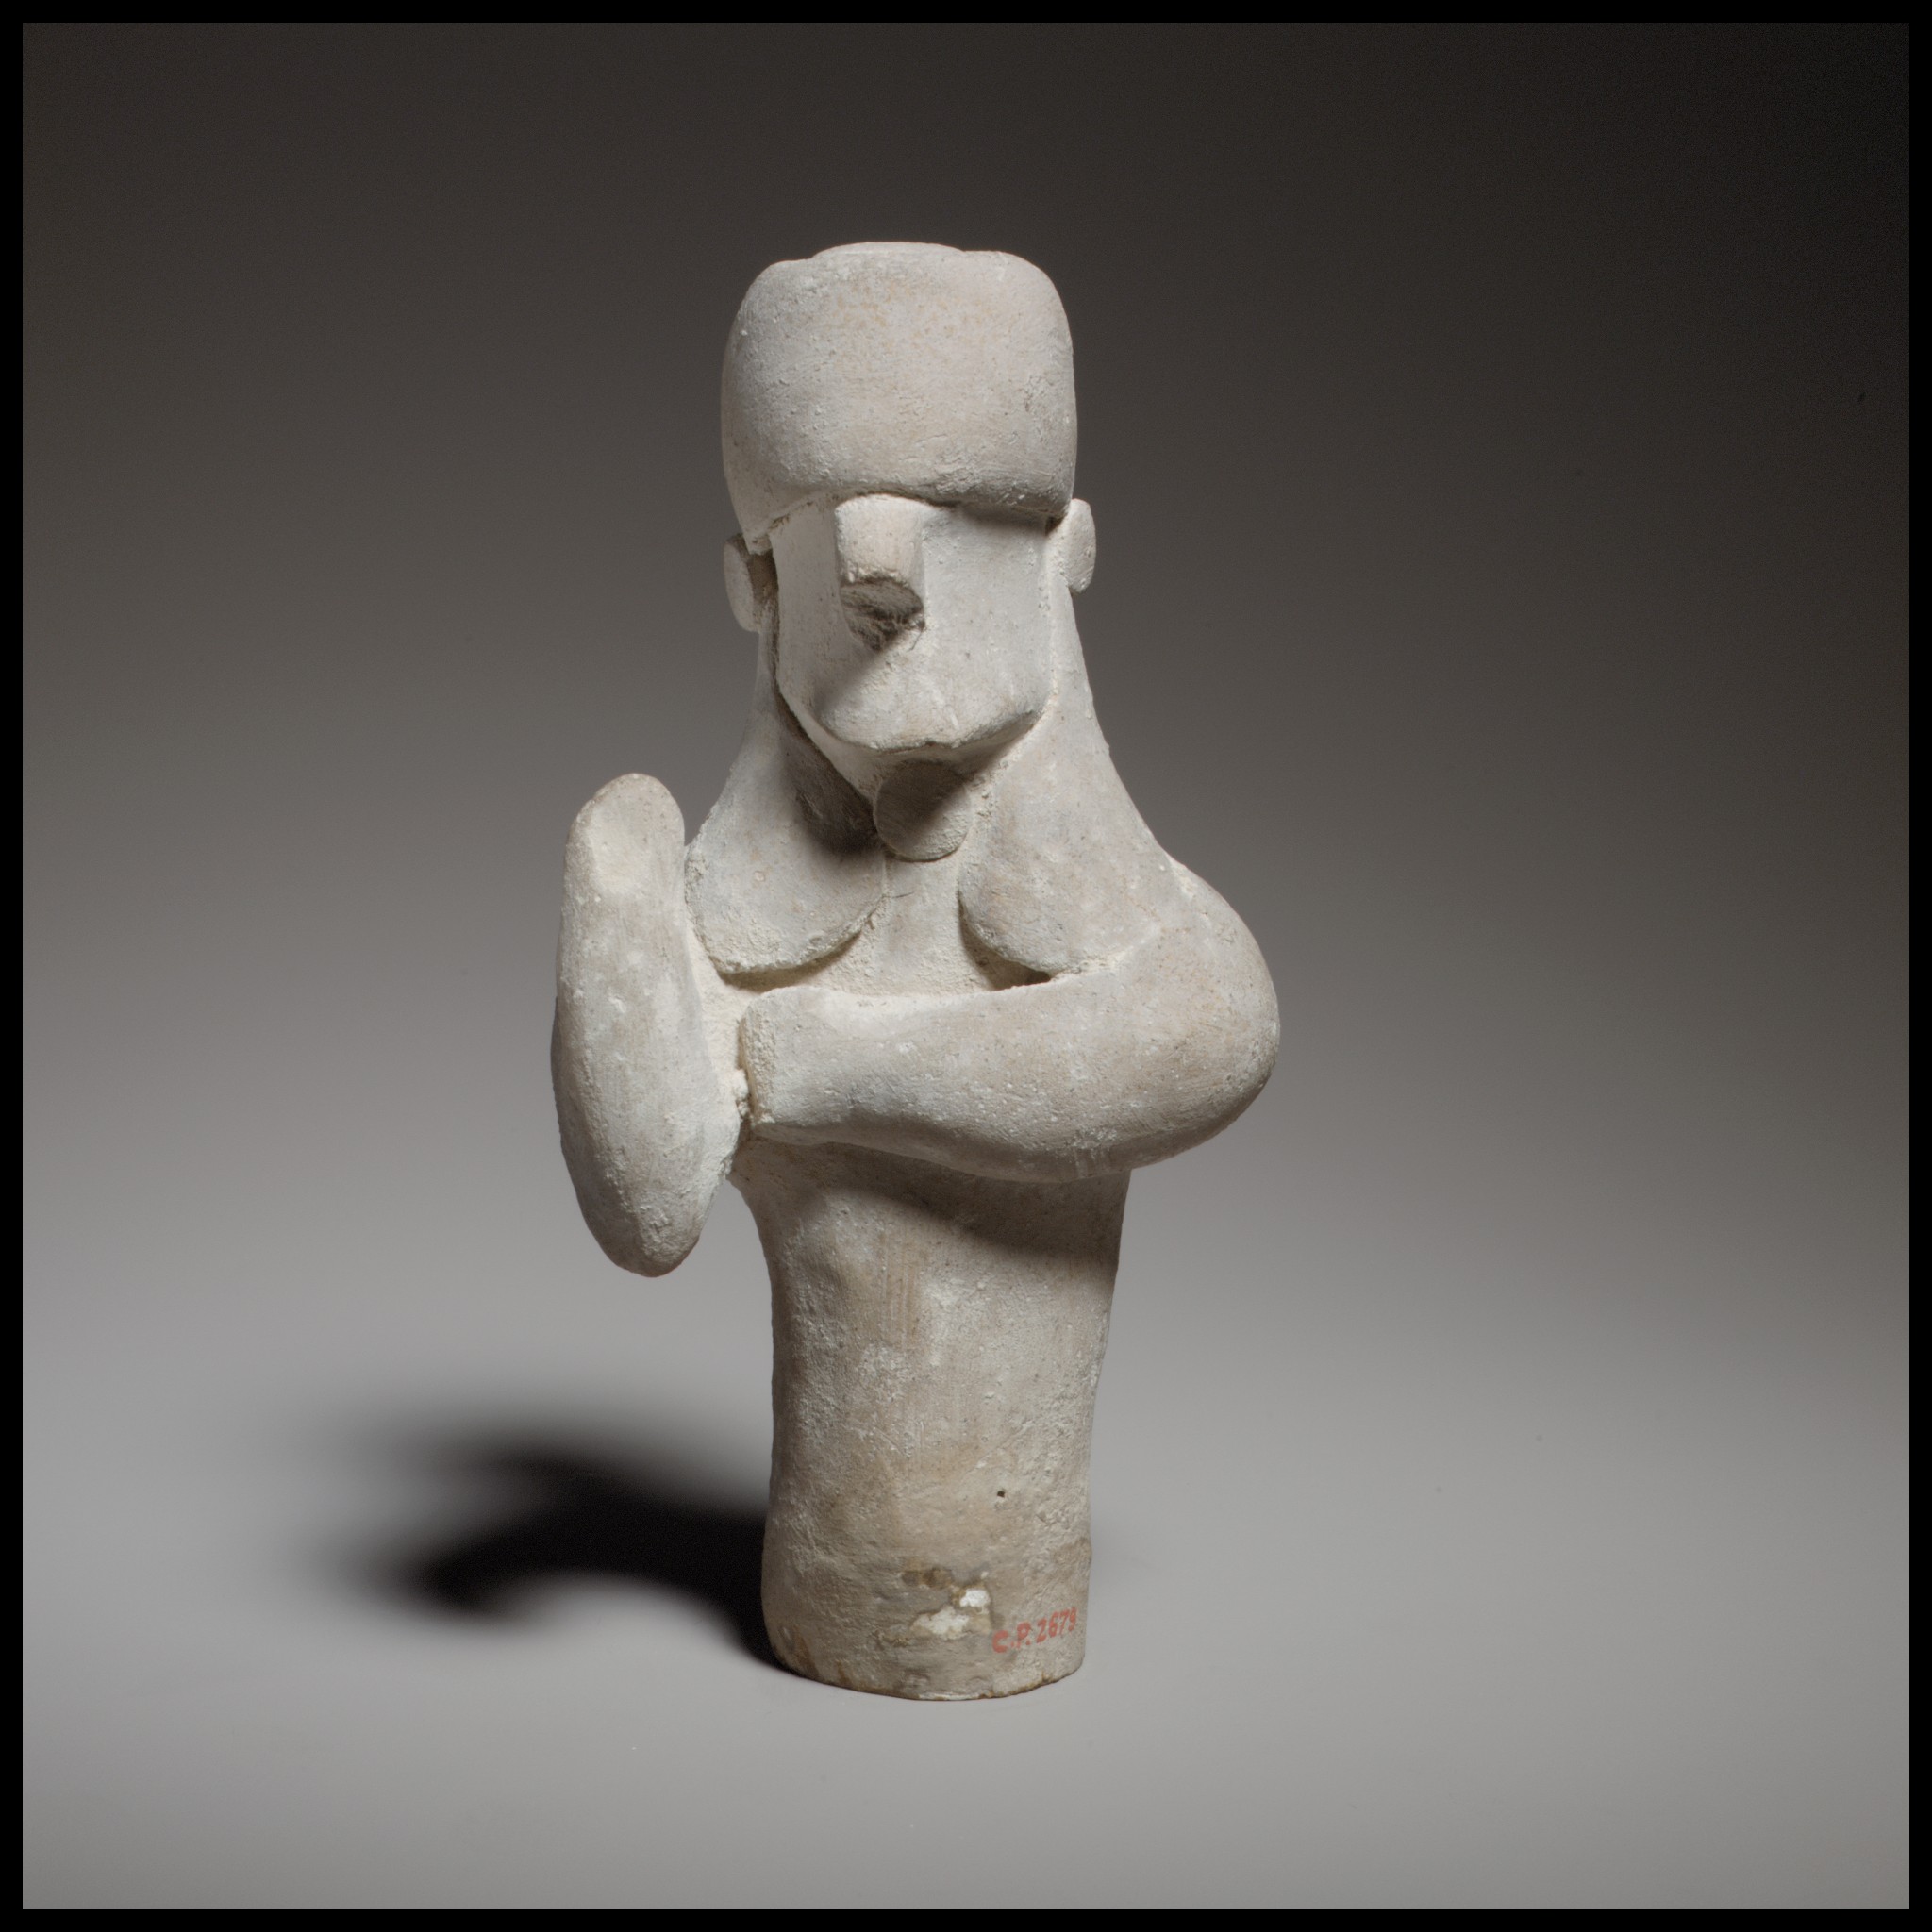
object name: statuette of a votary, male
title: Standing male figurine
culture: cypriot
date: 600-480 BCE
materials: terracotta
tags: men